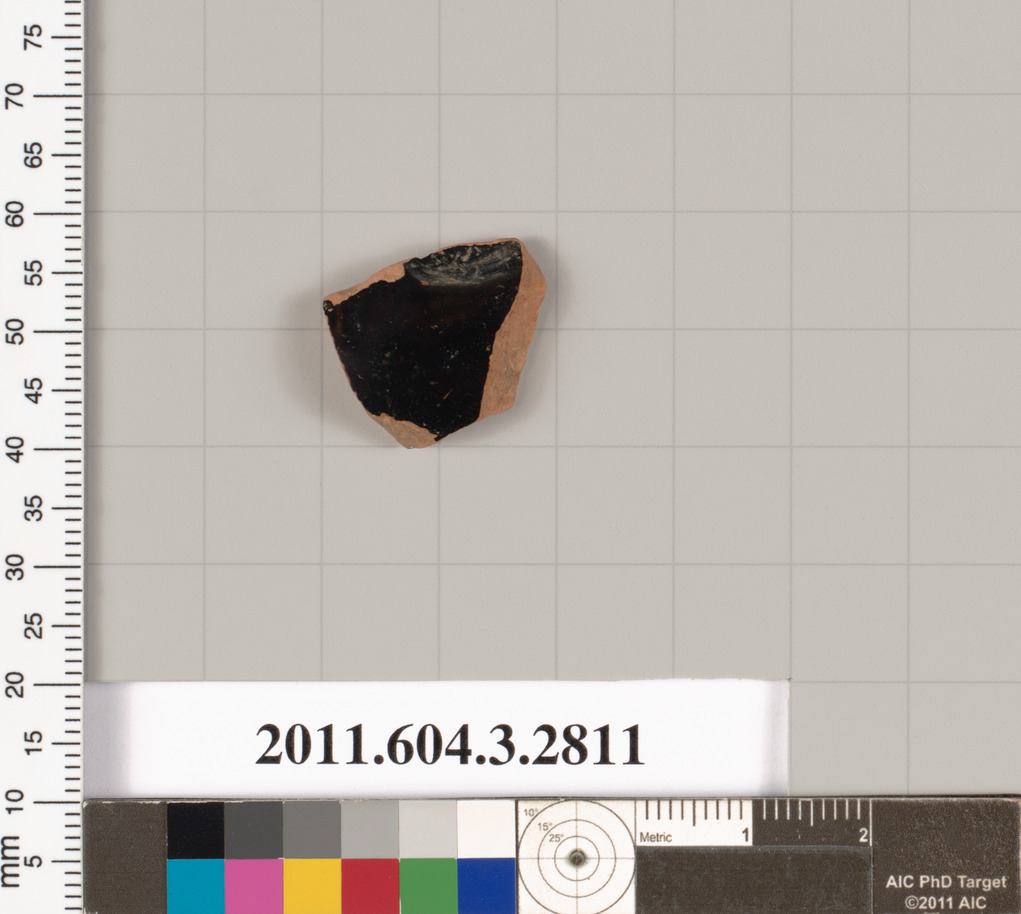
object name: rhyton fragment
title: Terracotta fragment of a rhyton (vase for libations or drinking)?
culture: greek, attic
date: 600-401 BCE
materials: terracotta